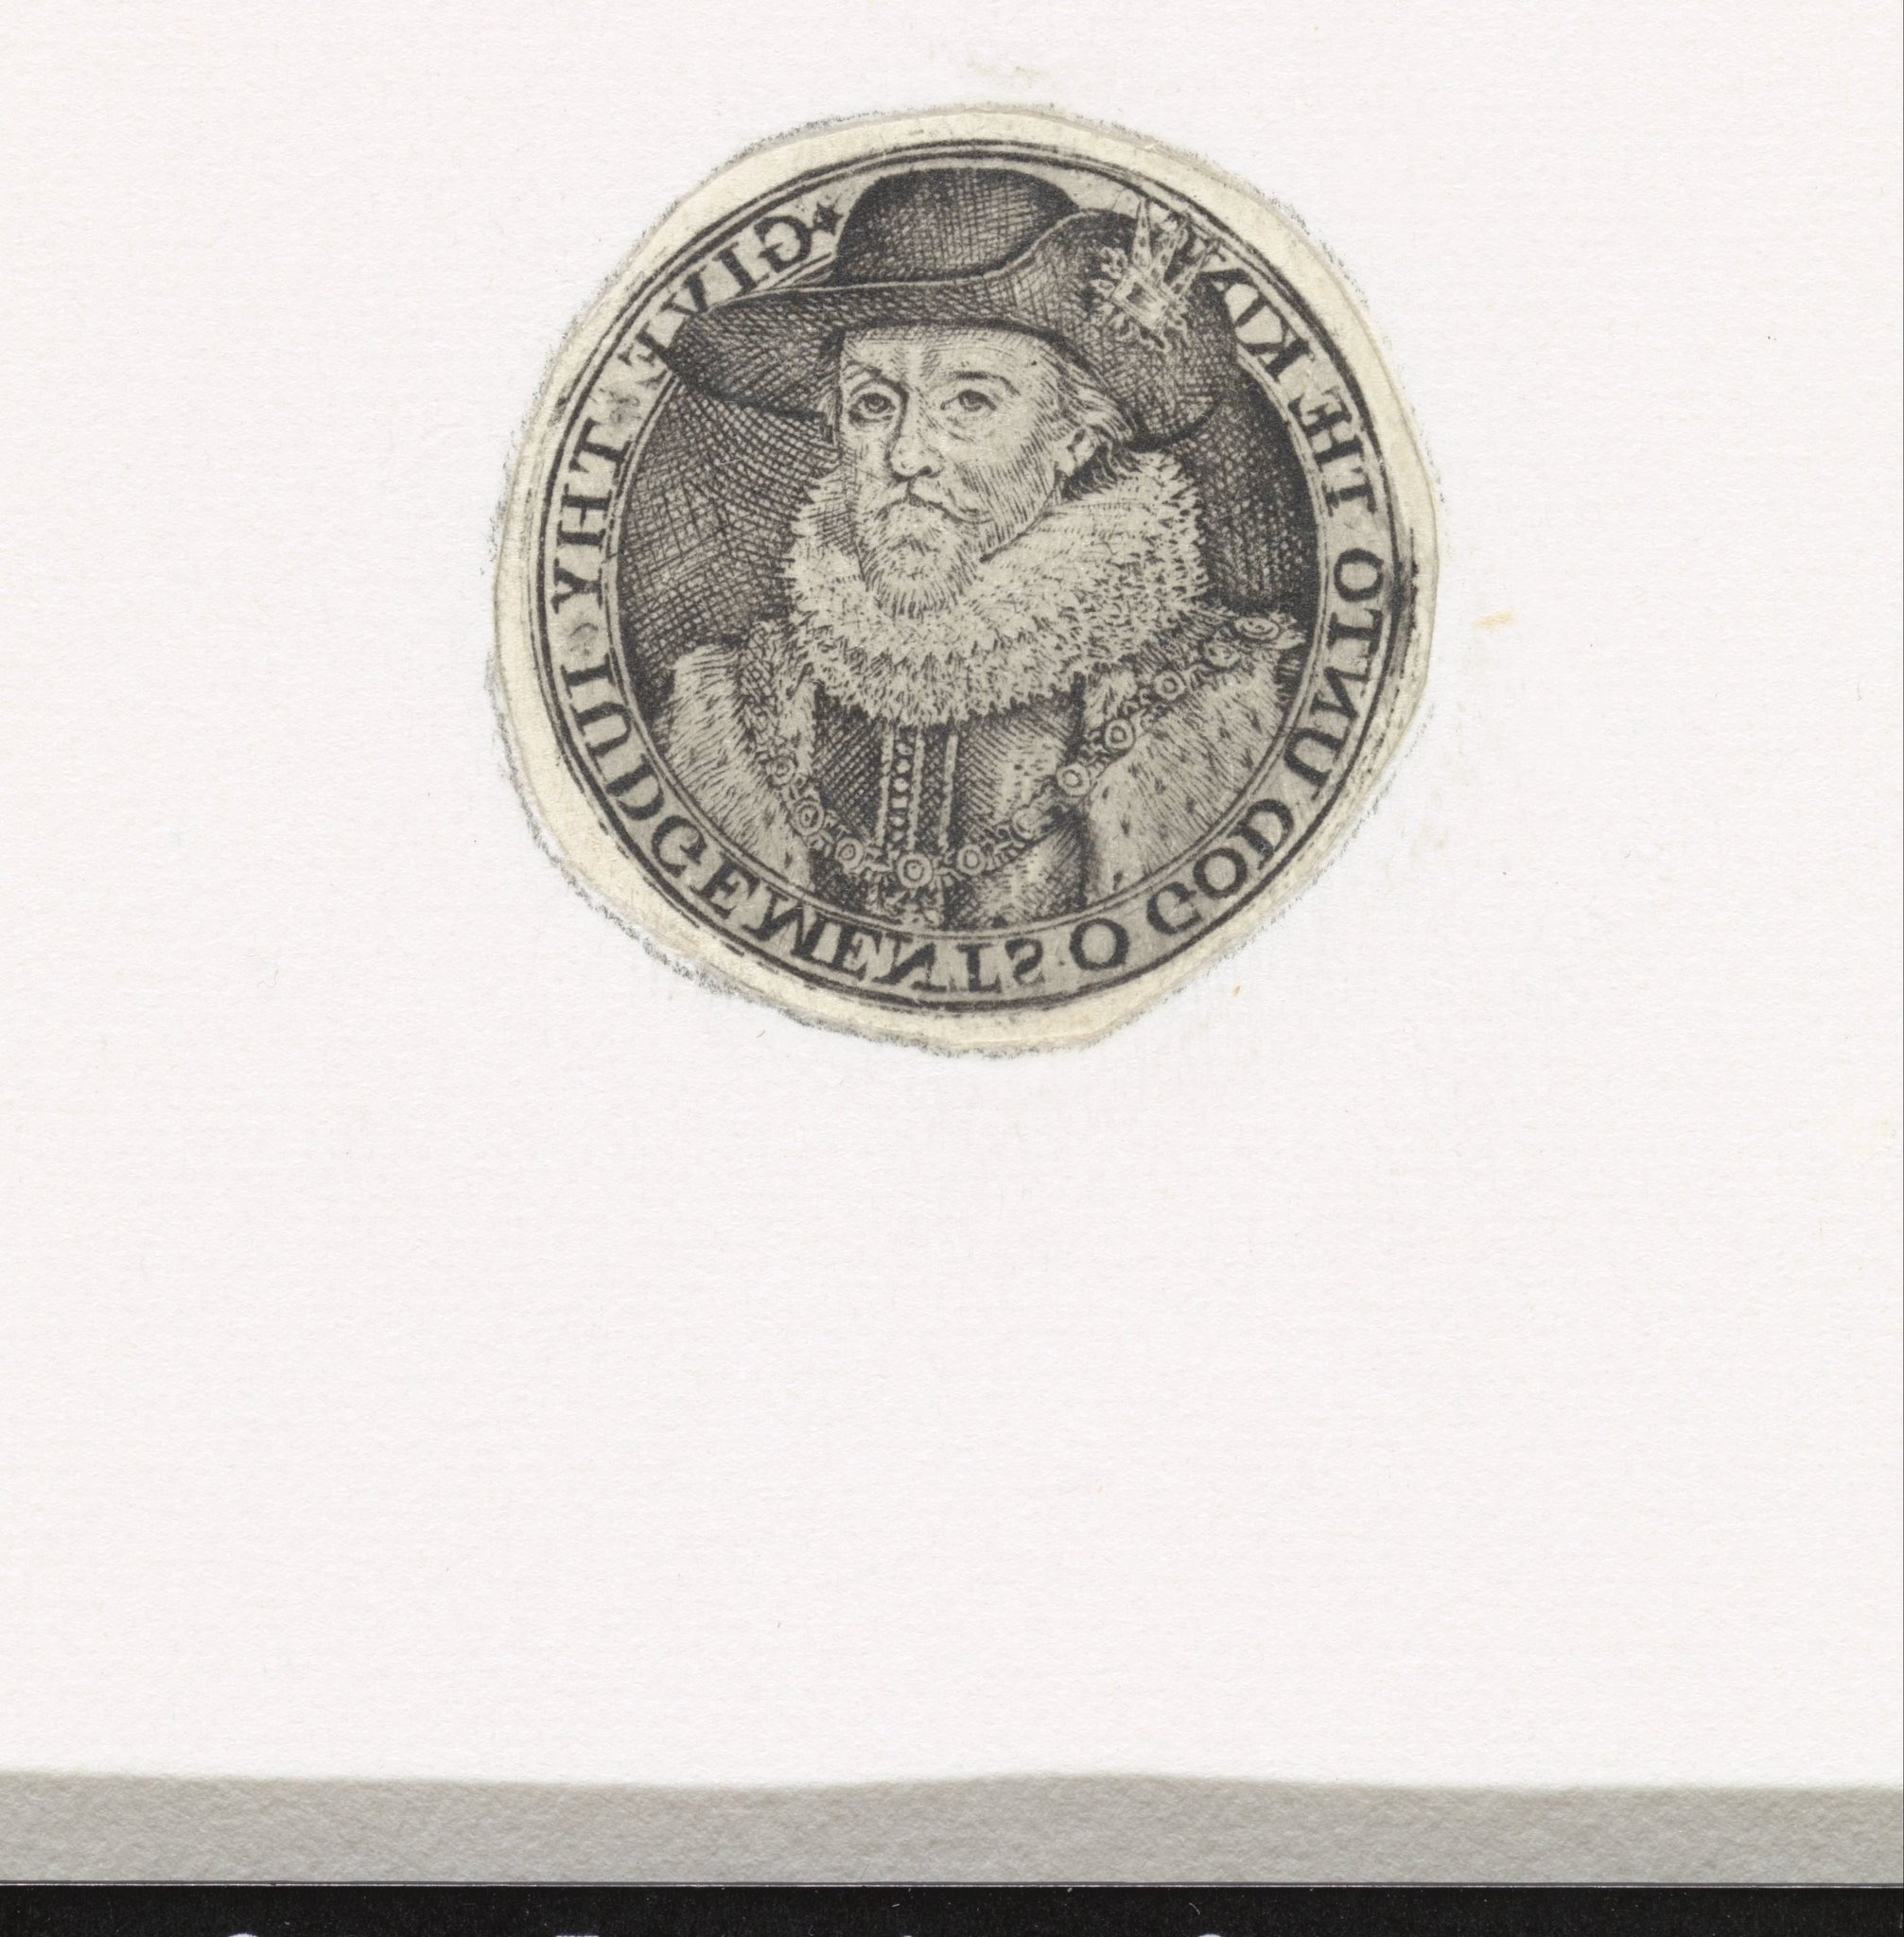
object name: print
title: Portret van Jacobus I, koning van Engeland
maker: simon van de passe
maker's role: print maker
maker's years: 1595-1647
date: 1616-1622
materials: paper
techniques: engraving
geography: london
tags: jacobus i (koning van engeland), historical persons, memorial medal, king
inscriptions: collector's mark: Lugt 2227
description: Tegenafdruk van een prent van een medaillon met het busteportret van James I, koning van Engeland, James VI, koning van Schotland. In het randschrift van de omlijsting een motto in het Engels. Op de andere zijde van de medaille het portret van zijn zoon.